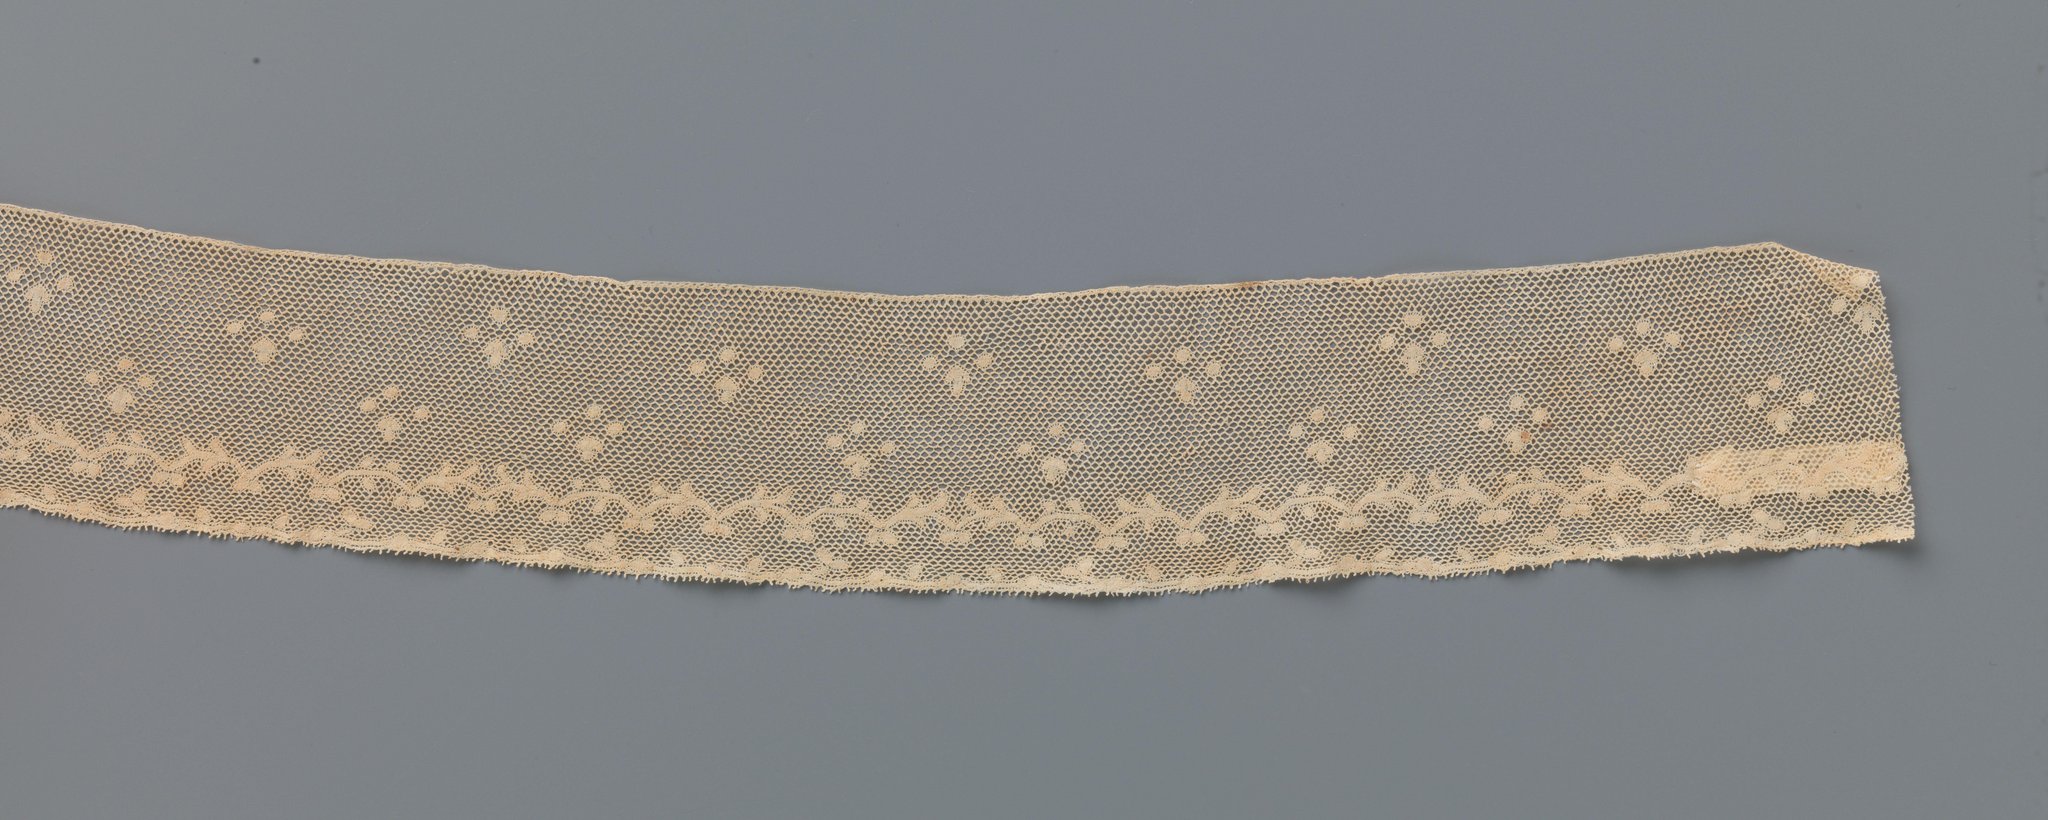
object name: strip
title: Strook kloskant met strooipatroon van blaadjes bekroond door drie losse stipjes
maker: Anonymous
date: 1785-1799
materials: linen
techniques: lace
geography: valenciennes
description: Strook naturelkleurige kloskant: Valenciennes-kant. Onder een strooipatroon van kleine drievoudige blaadjes bekroond door drie losse stipjes, loopt langs de onderrand een dubbele ijle rank met kleine blaadjes. De bovenste van de twee ranken loopt in boogjes, de rank die direct langs de onderzijde loopt is recht. De motieven zijn met elkaar verbonden door een maasgrond, de ruitvormige Valenciennes-grond. De motieven zijn gemaakt in linnenslag met opengewerkte randjes. Boven- en onderzijde zijn recht afgewerkt, waarbij de onderzijde is voorzien van picots.